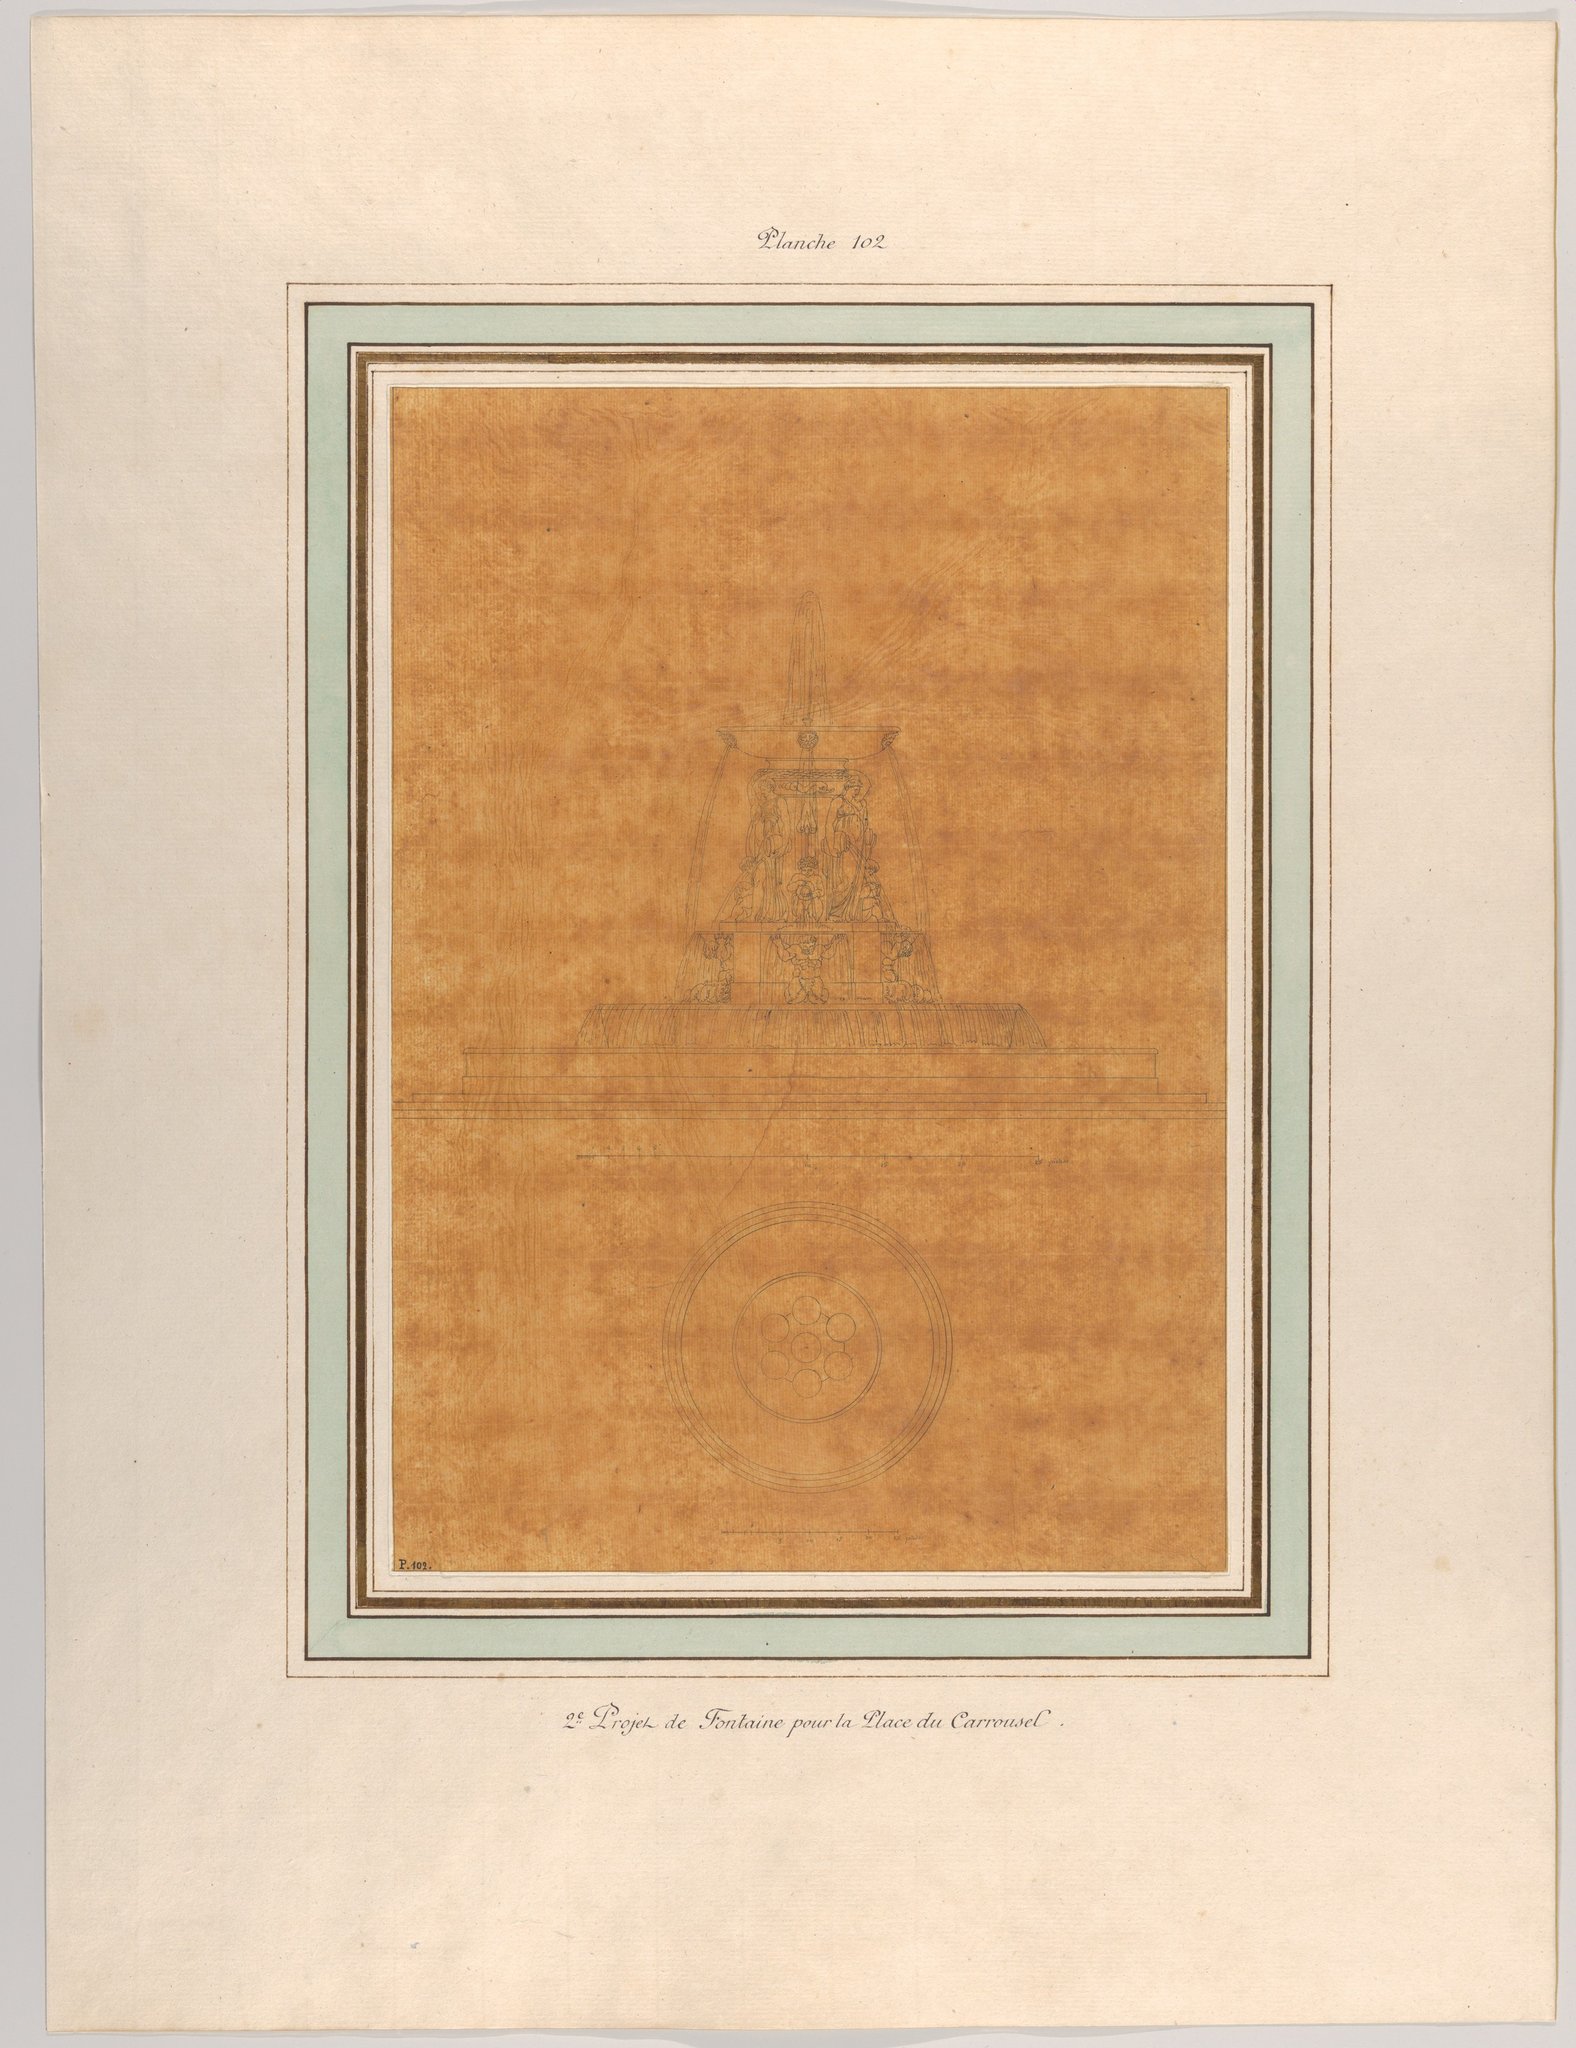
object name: drawing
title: Project for a Fountain for La Place du Carrousel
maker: pierre françois léonard fontaine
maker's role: artist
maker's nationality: french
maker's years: 1762-1853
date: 1806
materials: ink, paper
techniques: pen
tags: fountains